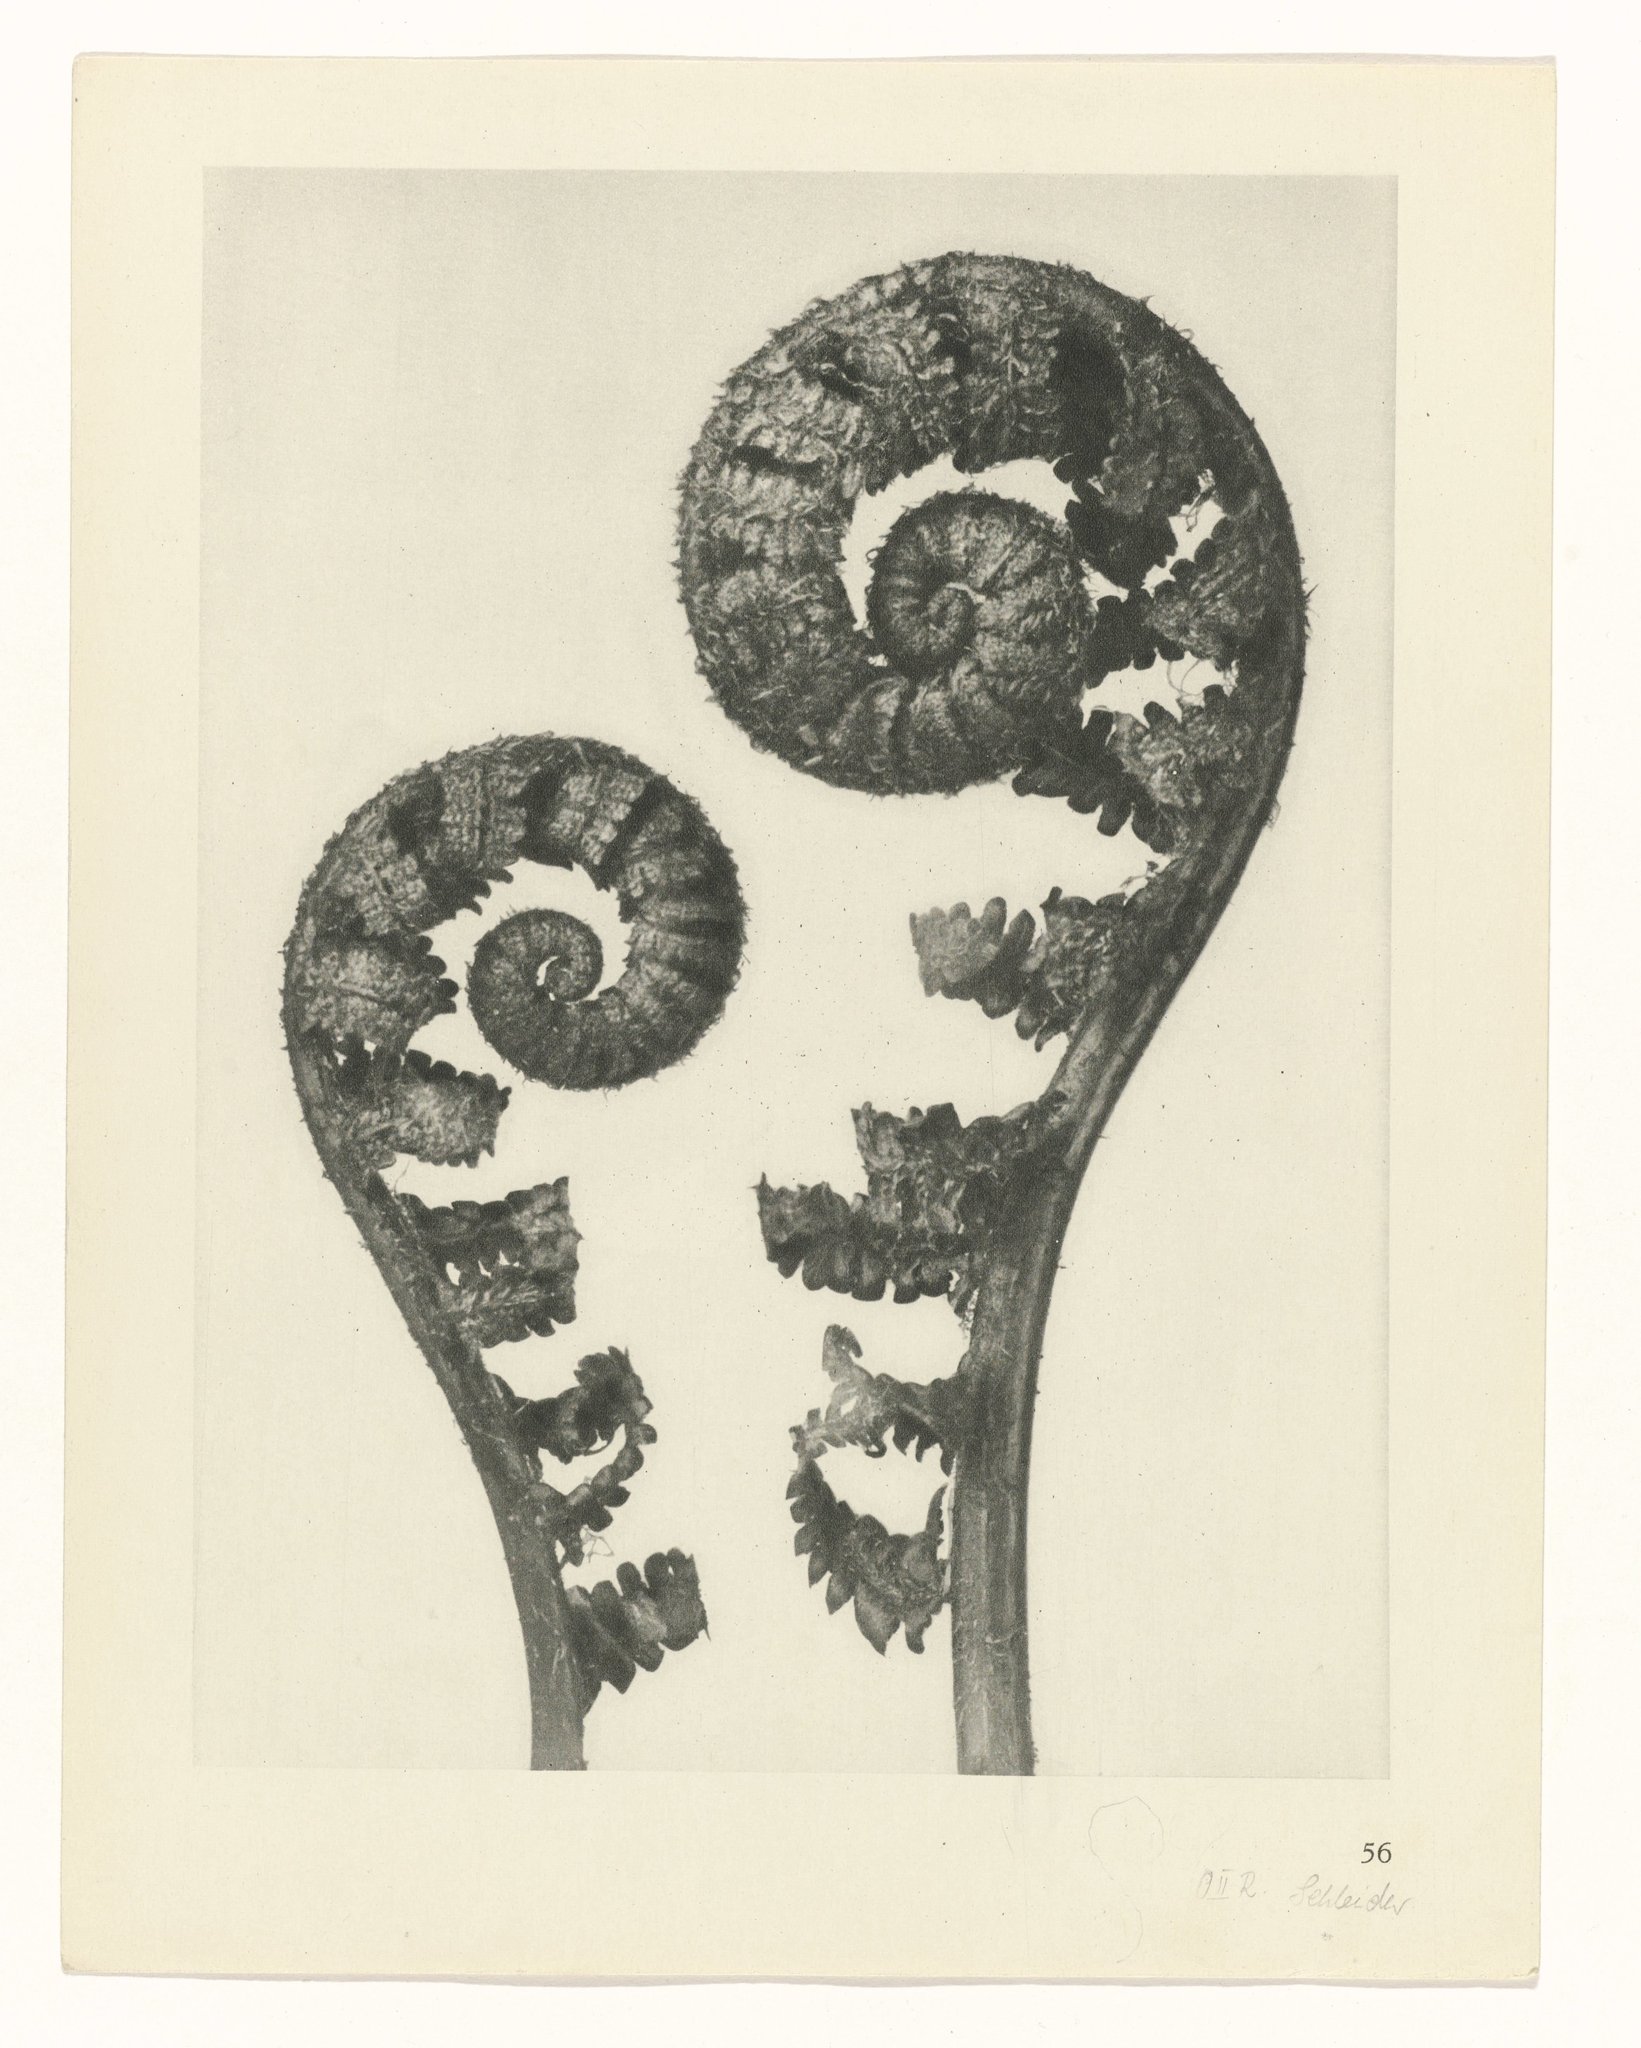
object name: photograph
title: Plantstudie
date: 1928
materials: ink, paper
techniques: rotogravure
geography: berlin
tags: plants (in general)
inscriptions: number: ‘56’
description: facher Vergrößerung. Afkomstig uit losbladige uitgave.